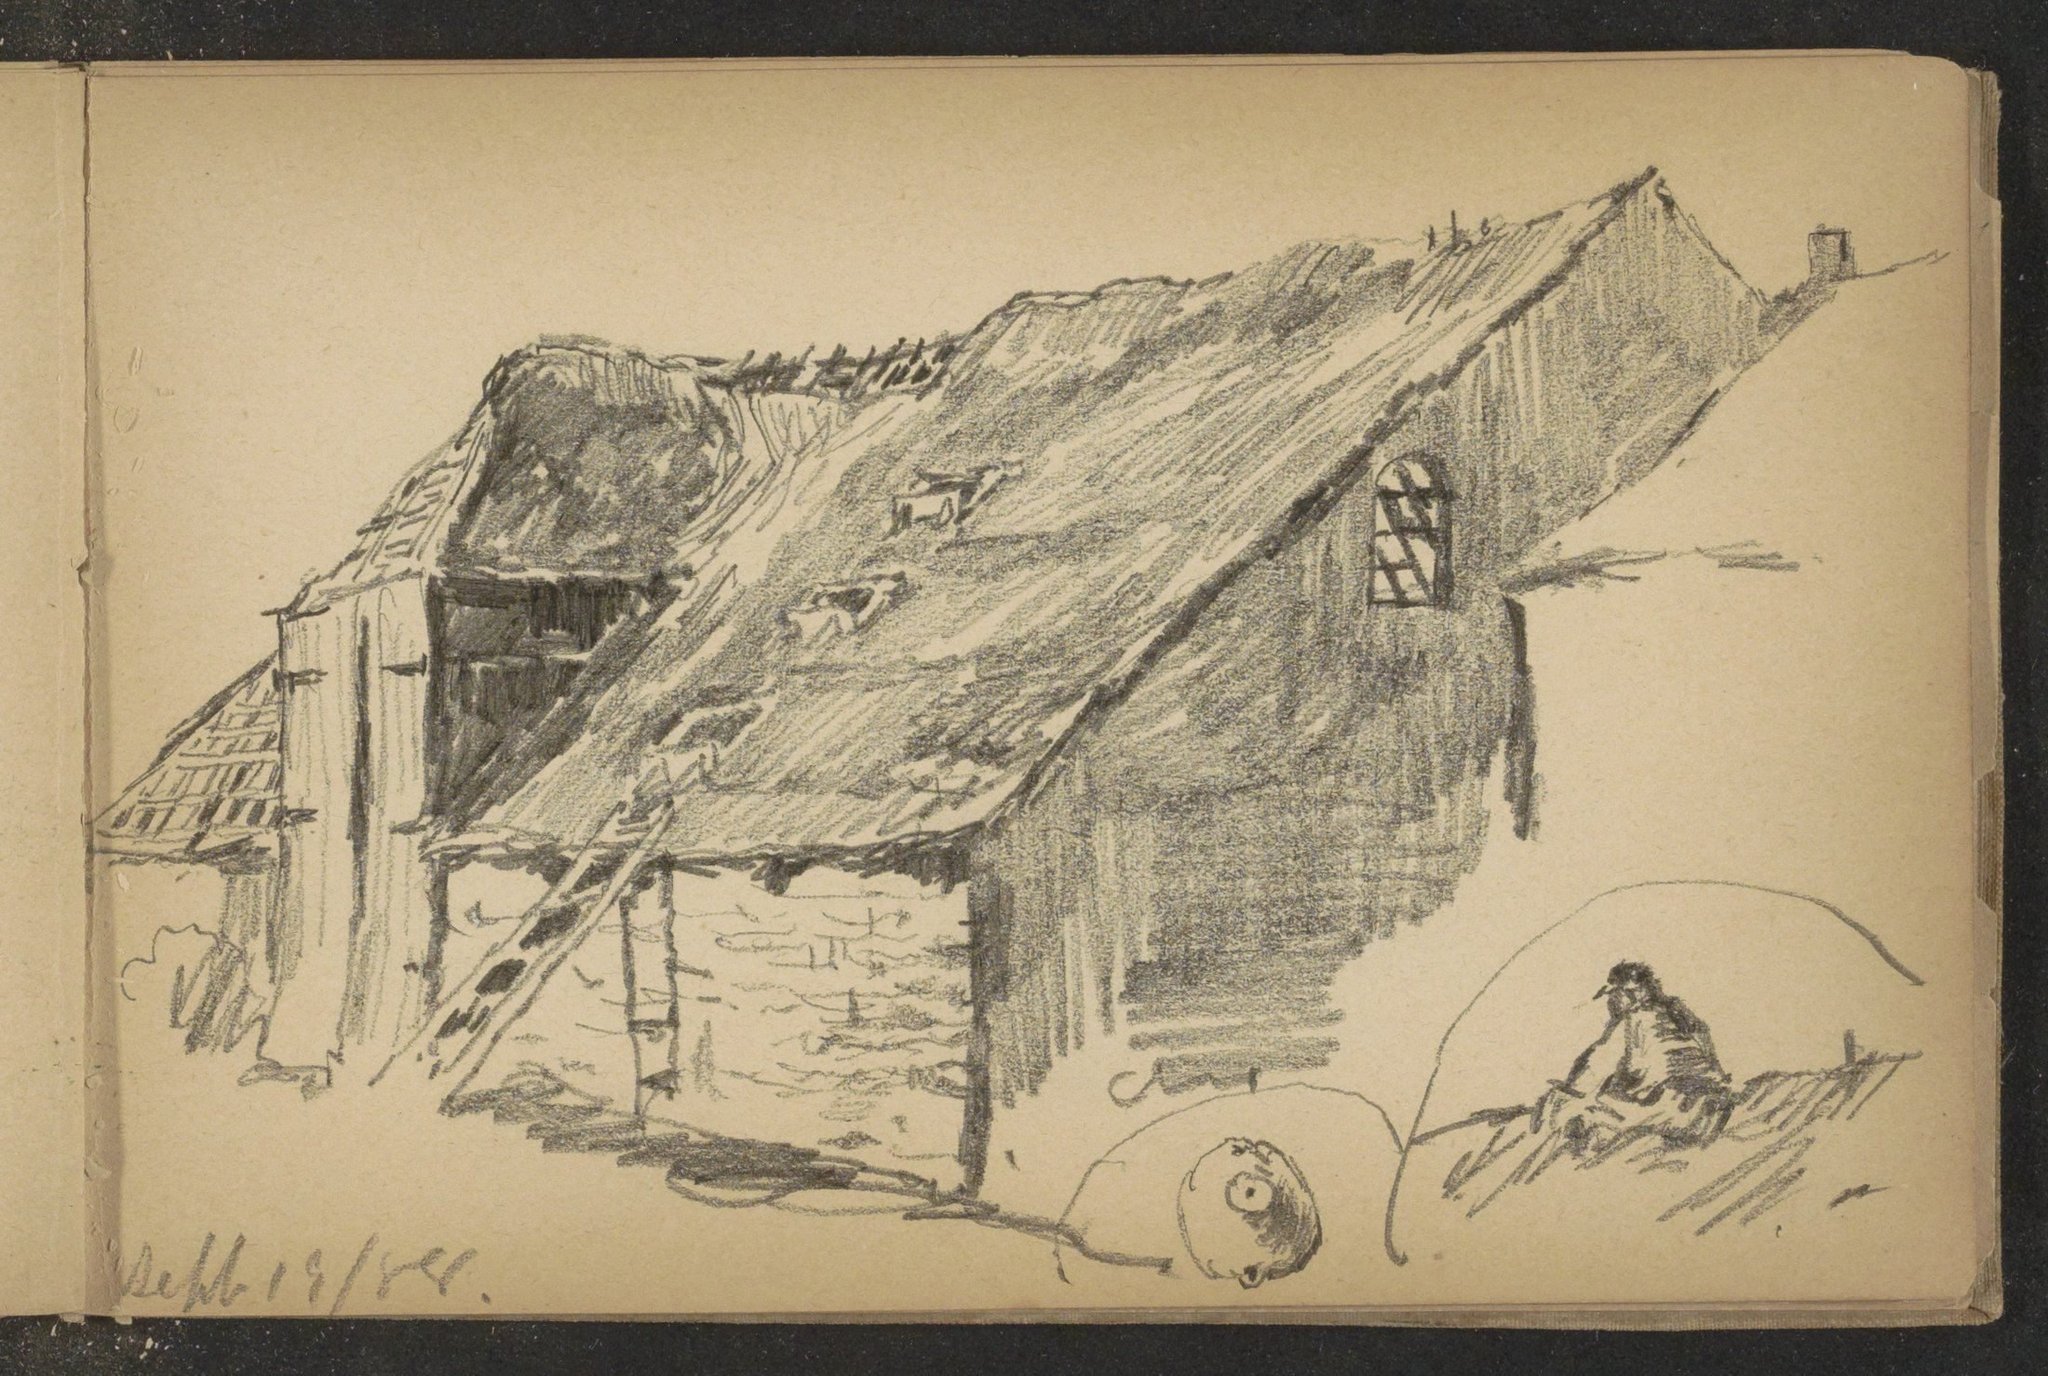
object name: sketchbook leaf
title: Schuur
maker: alexander shilling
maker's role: draughtsman, print maker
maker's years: 1859-1937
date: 1809-1888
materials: paper, pencil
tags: barn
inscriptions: date: ‘sept 19/88’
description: Tevens een studie van een man op een (schuur)dak, mogelijk een dakdekker. Blad 30 recto uit een schetsboek met 34 bladen.